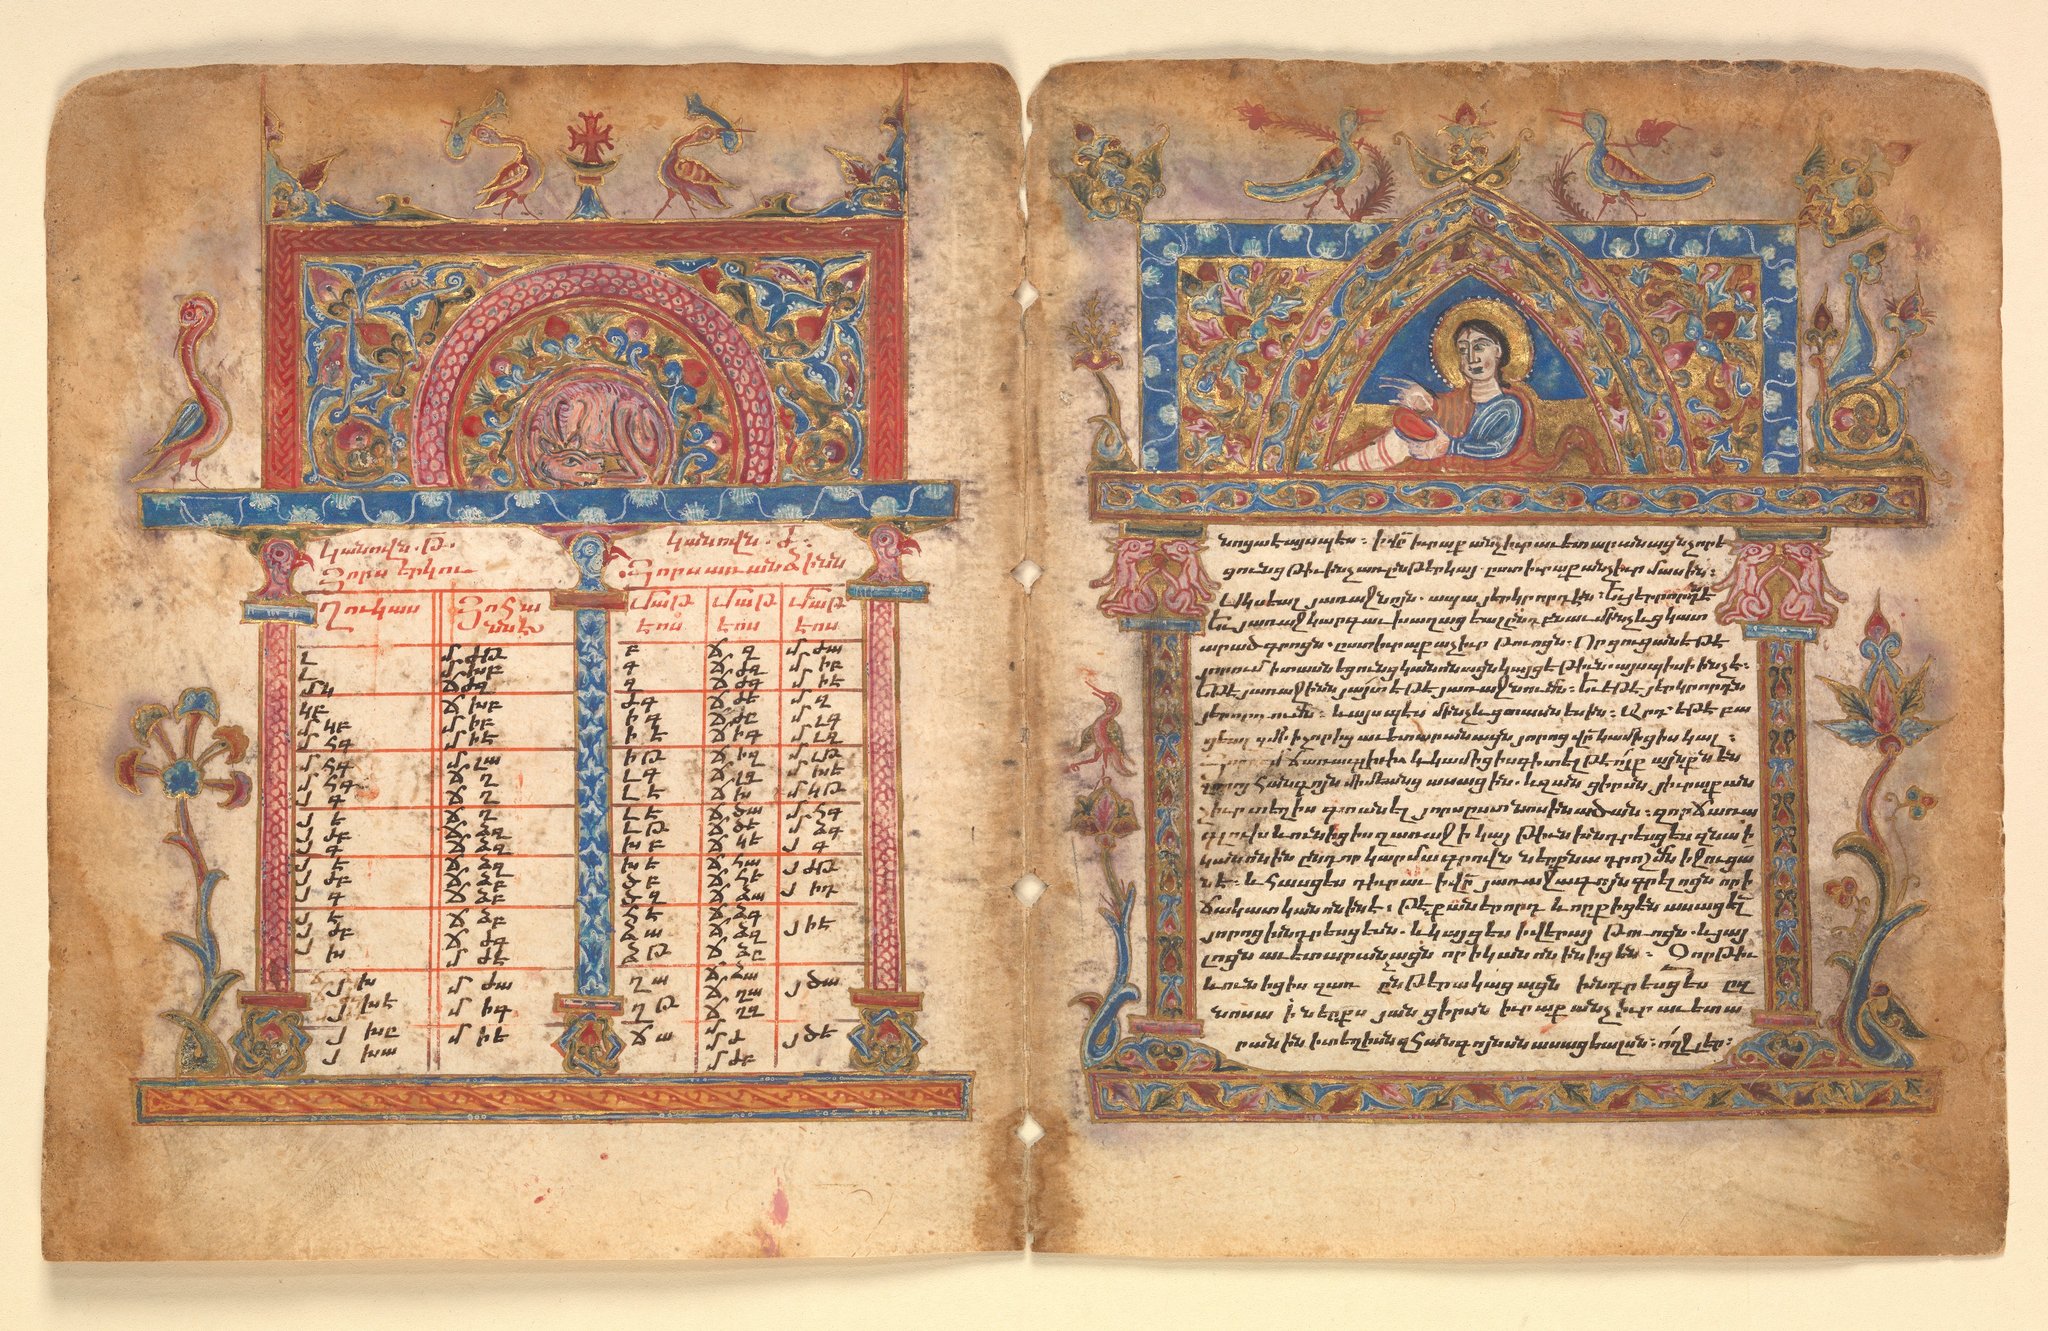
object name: bifolium from a non illustrated manuscript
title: Armenian Manuscript Bifolium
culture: armenian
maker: illuminator minas (?)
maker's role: artist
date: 1401-1500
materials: gold leaf, paper, paint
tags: birds,men